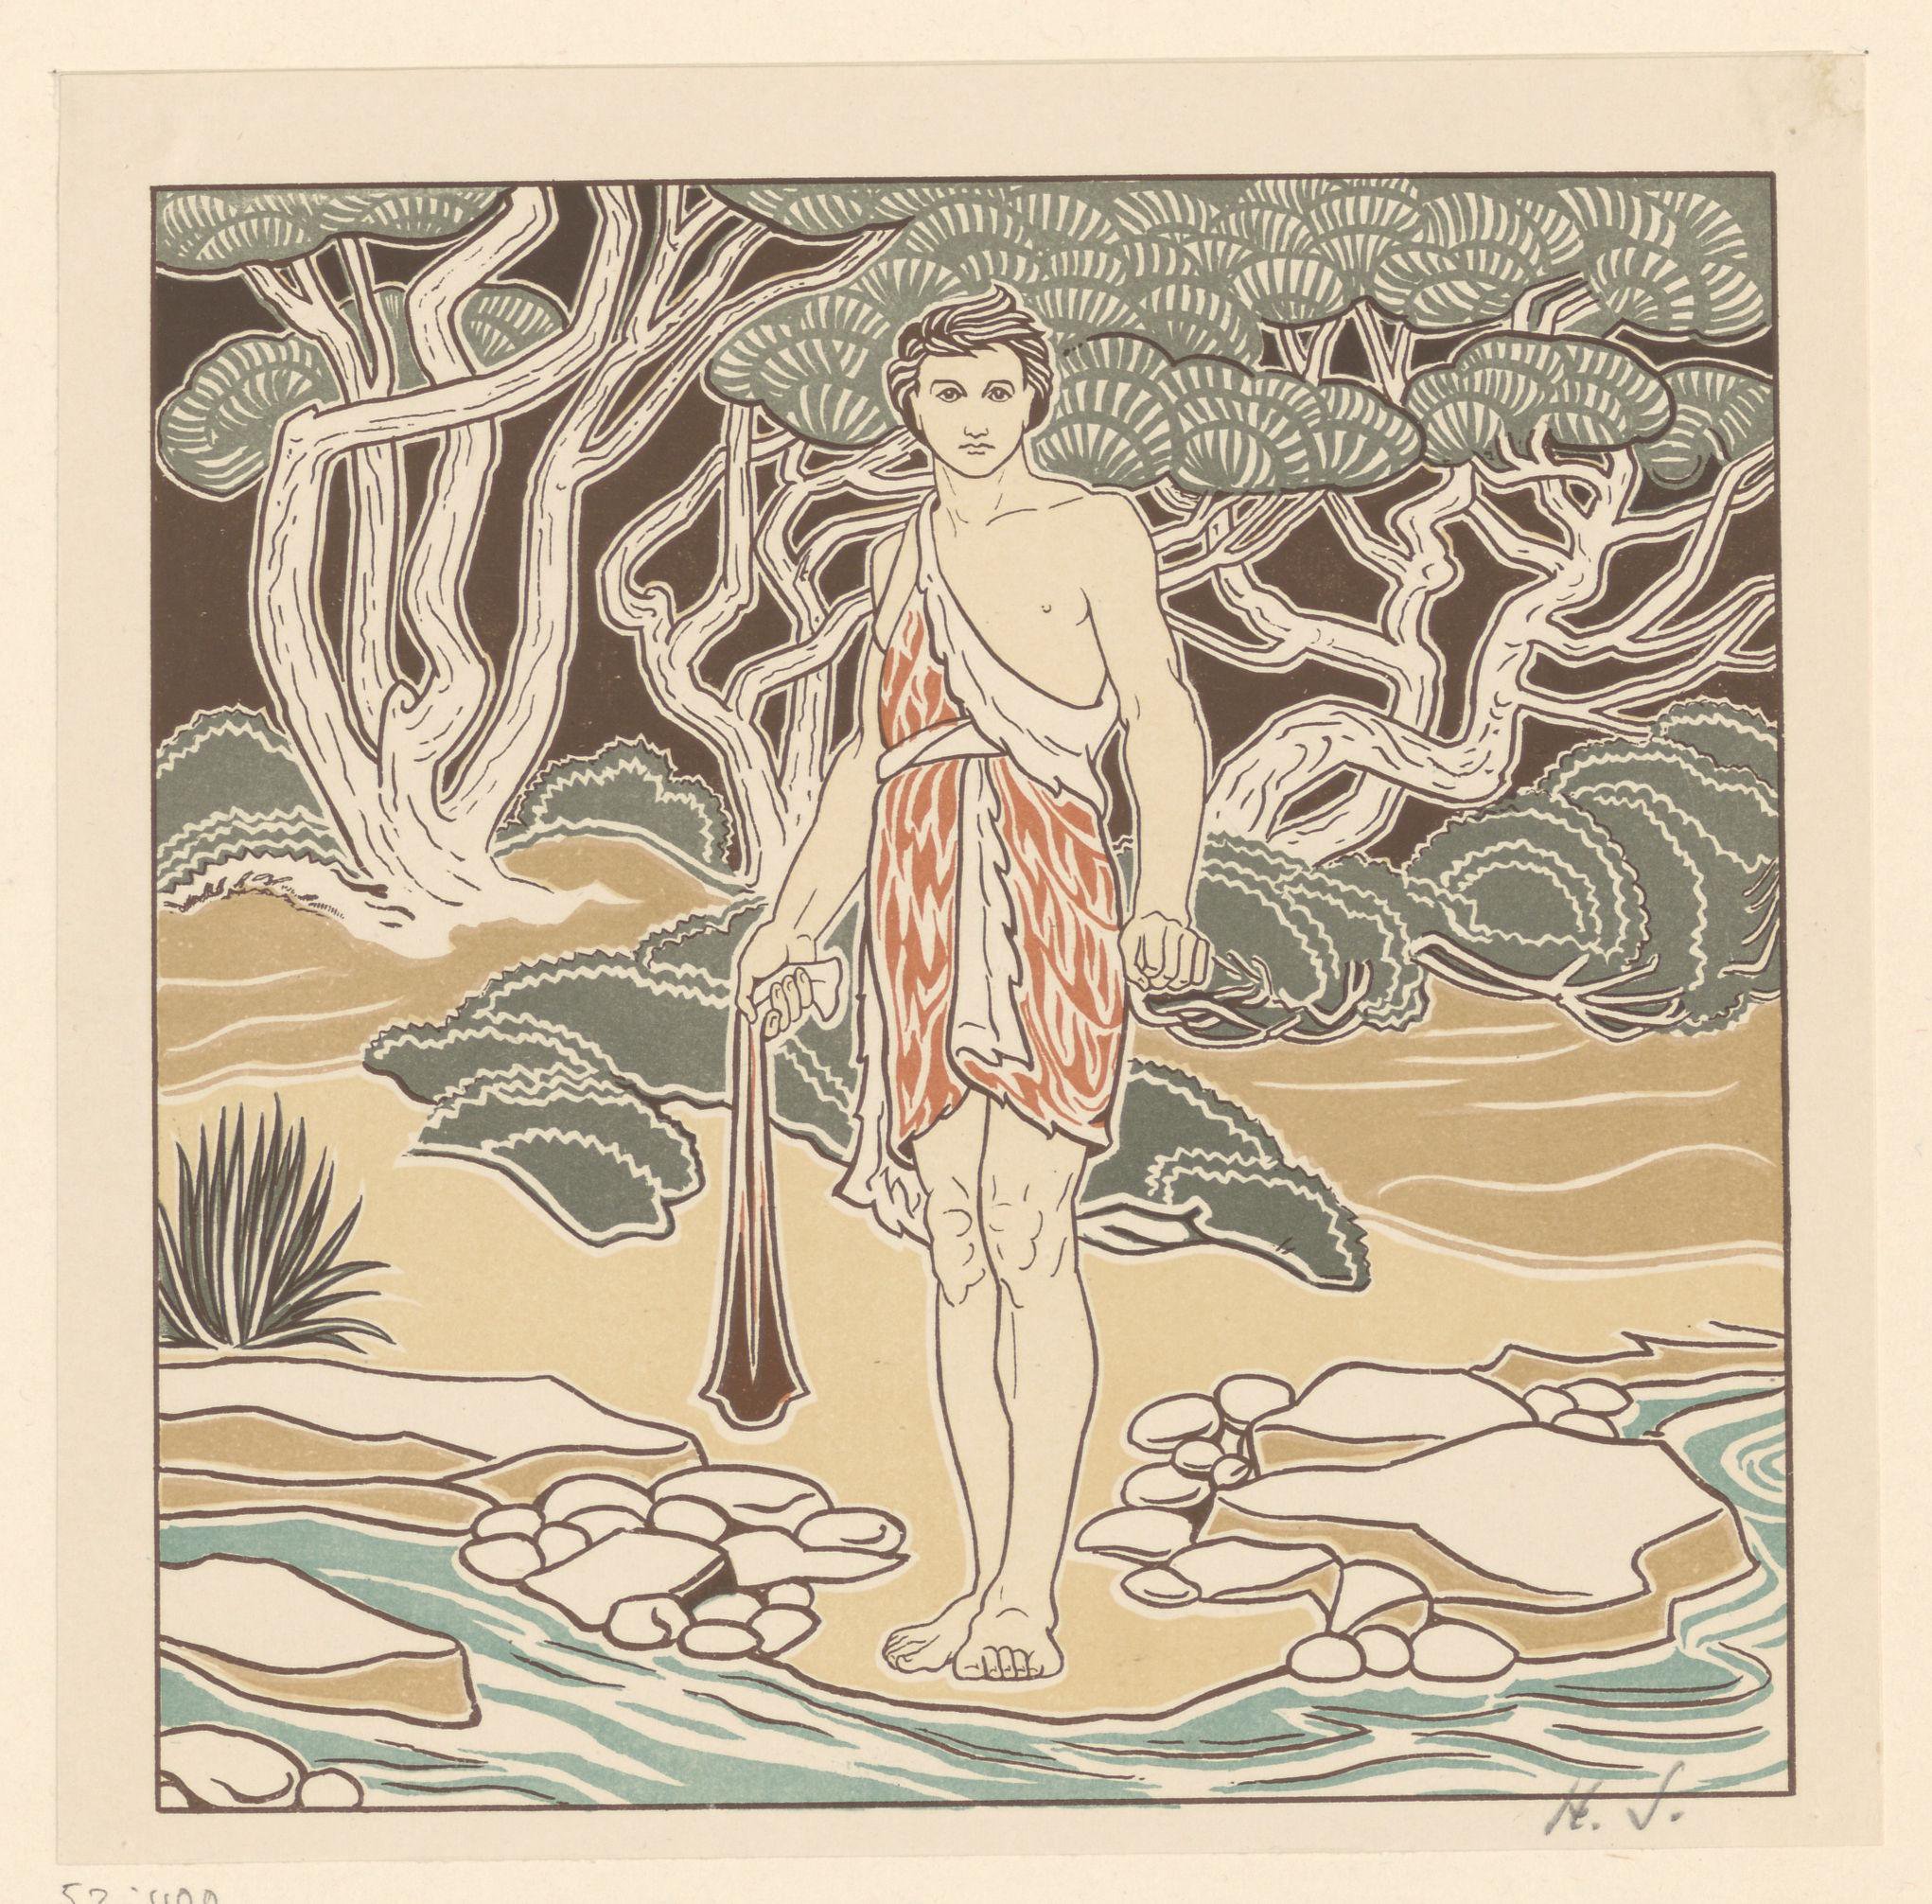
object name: print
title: David met slinger bij een beek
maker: george heywood maunoir sumner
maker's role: print maker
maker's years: 1853-1940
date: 1898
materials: paper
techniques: lithograph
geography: london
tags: landscapes with waters, waterscapes, seascapes (in the temperate zone), story of david, casting weapons: sling